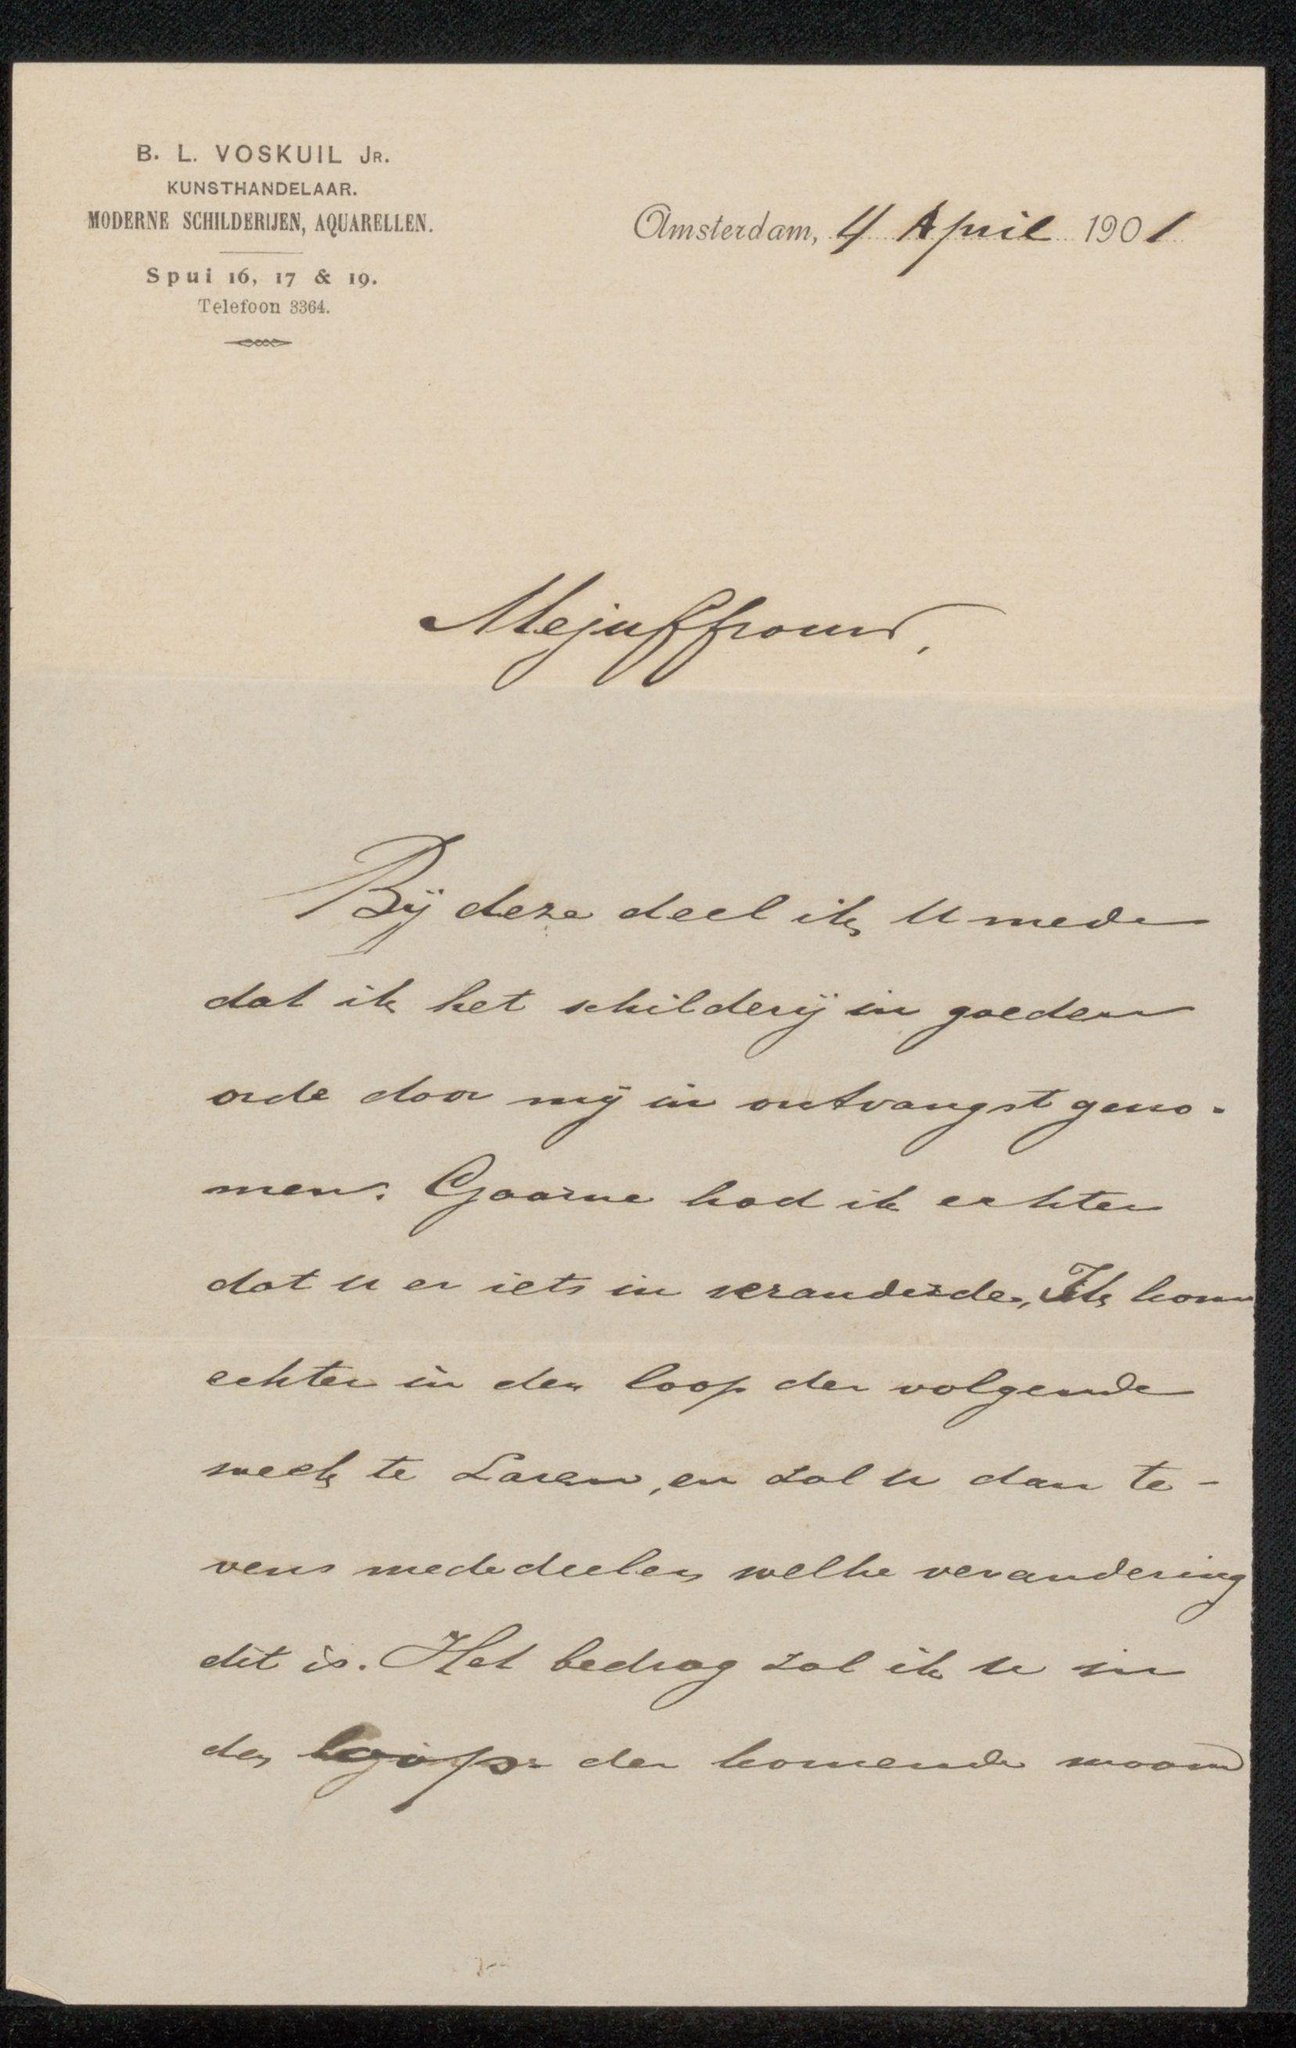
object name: letter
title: Brief aan Wally Moes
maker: bartholomeus lambertus voskuil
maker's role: auctioneer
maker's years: 1866-1941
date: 1901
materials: ink, paper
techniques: pen, printing, writing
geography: amsterdam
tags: print maker, draughtsman, wally moes, painting (including book-illumination, miniature-painting), money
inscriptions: collector's mark: ‘RPK’